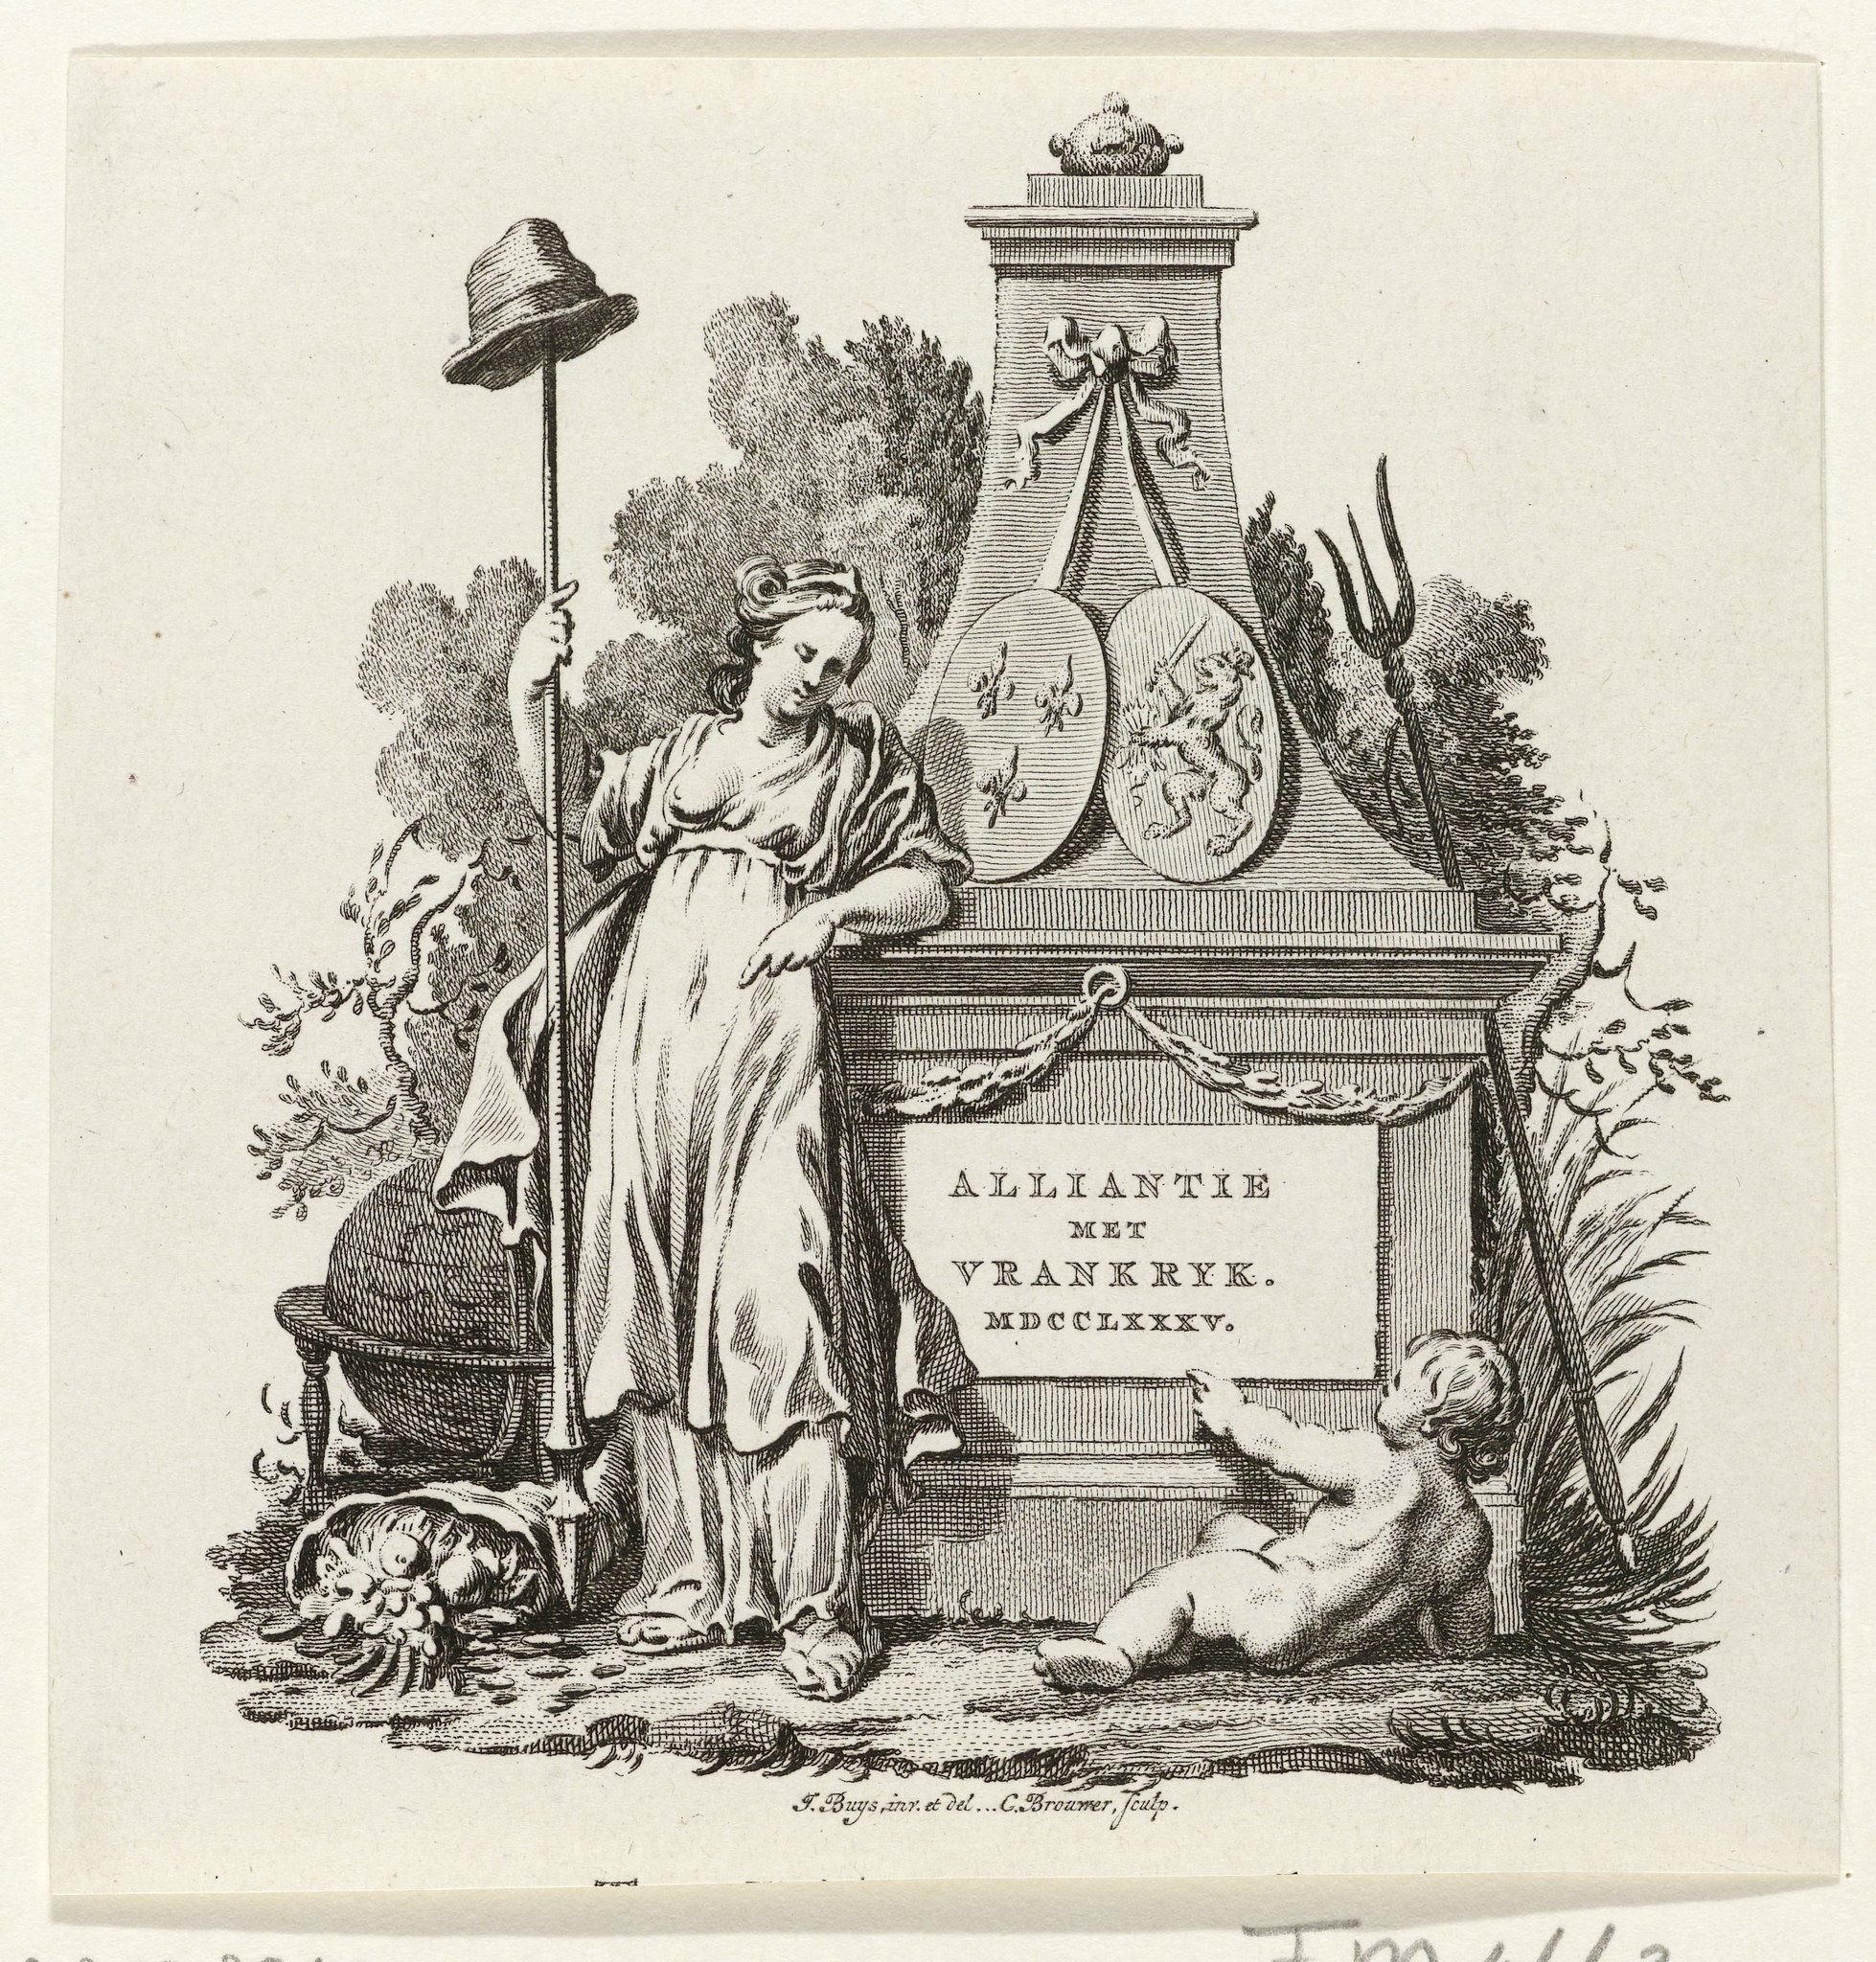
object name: titelblad, titelpagina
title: Titelpagina uit: De Post van den Neder-Rhijn, dl. VIII, 1786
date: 1786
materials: paper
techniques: engraving, etching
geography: northern netherlands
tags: freedom, liberty; 'libertà' (ripa) (+ abstract concept represented by female figure), alliance with france (1785)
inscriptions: collector's mark: Lugt 2228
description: Titelpagina van het patriotische tijdschrift De Post van den Neder-Rhijn, dl. VIII, 1786. Uitgeknipt vignet met een allegorische voorstelling met de Vrijheid staande naast een monument met opschrift: Alliantie met Vrankryk. MDCCLXXXV. Op de alliantie tussen de Republiek en Frankrijk, 10 november 1785.